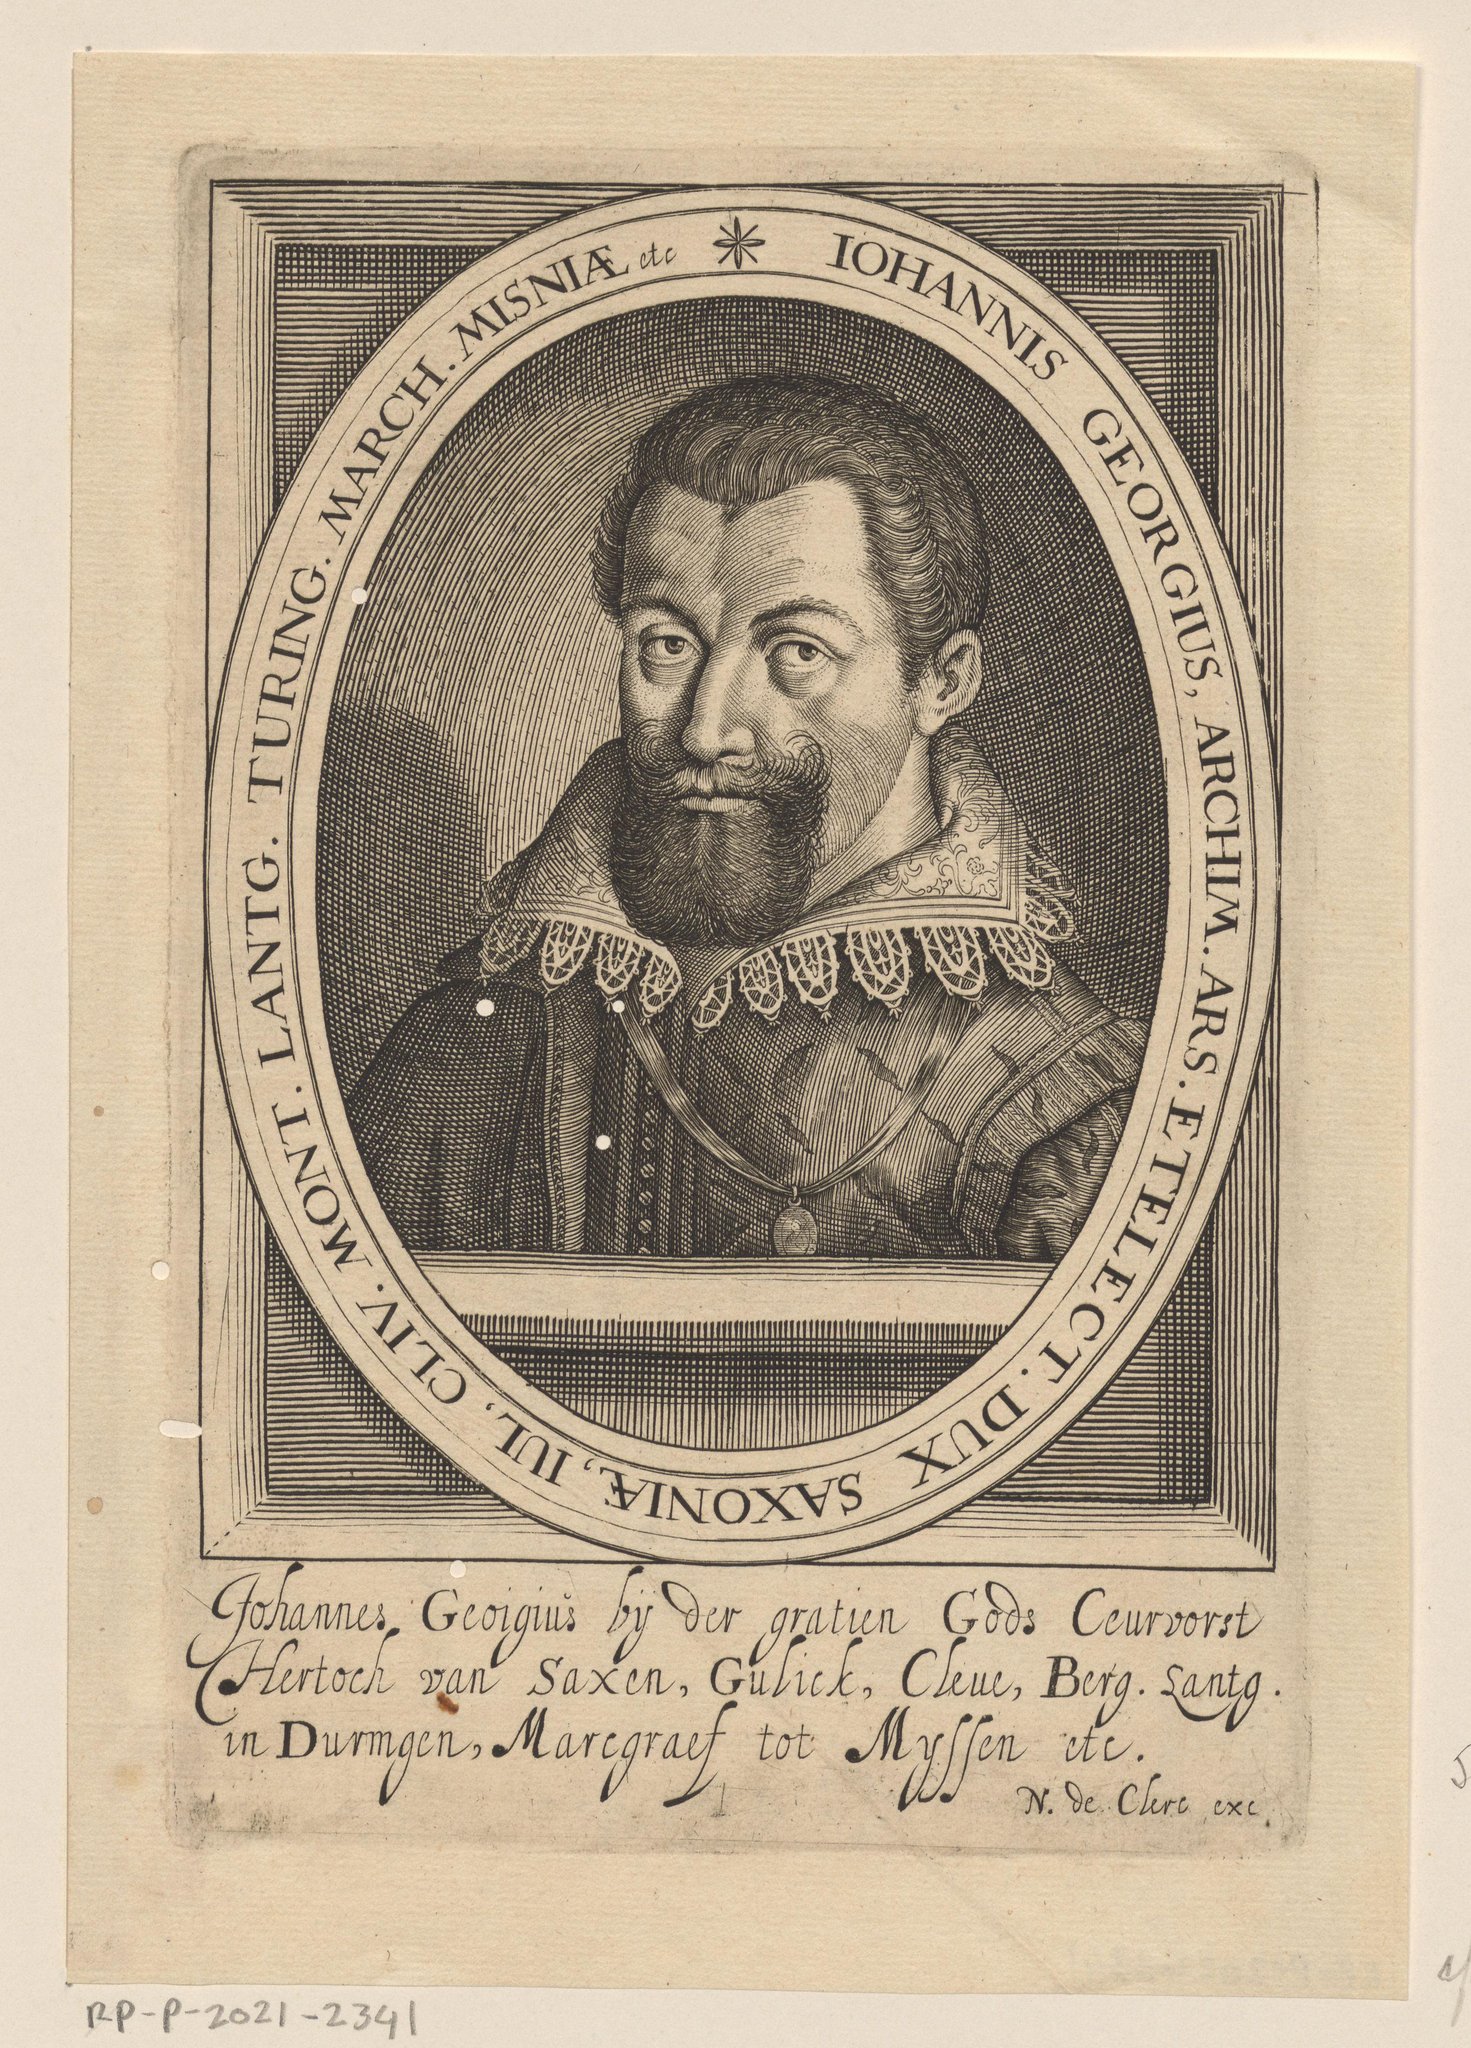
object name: print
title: Portret van Johann George I van Saksen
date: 1599-1623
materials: paper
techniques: engraving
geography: delft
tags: johann george van saksen (i), (story of) minerva (pallas, athena), historical persons, ruler, sovereign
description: Prent met tekst op verso gebruikt in: Princelyck cabinet, verthoonende t'leven afcomste ende afbeeldingen der voornaemste vorste (...). Delft: erven Nicolaes de Clerck, 1625, p. 51.